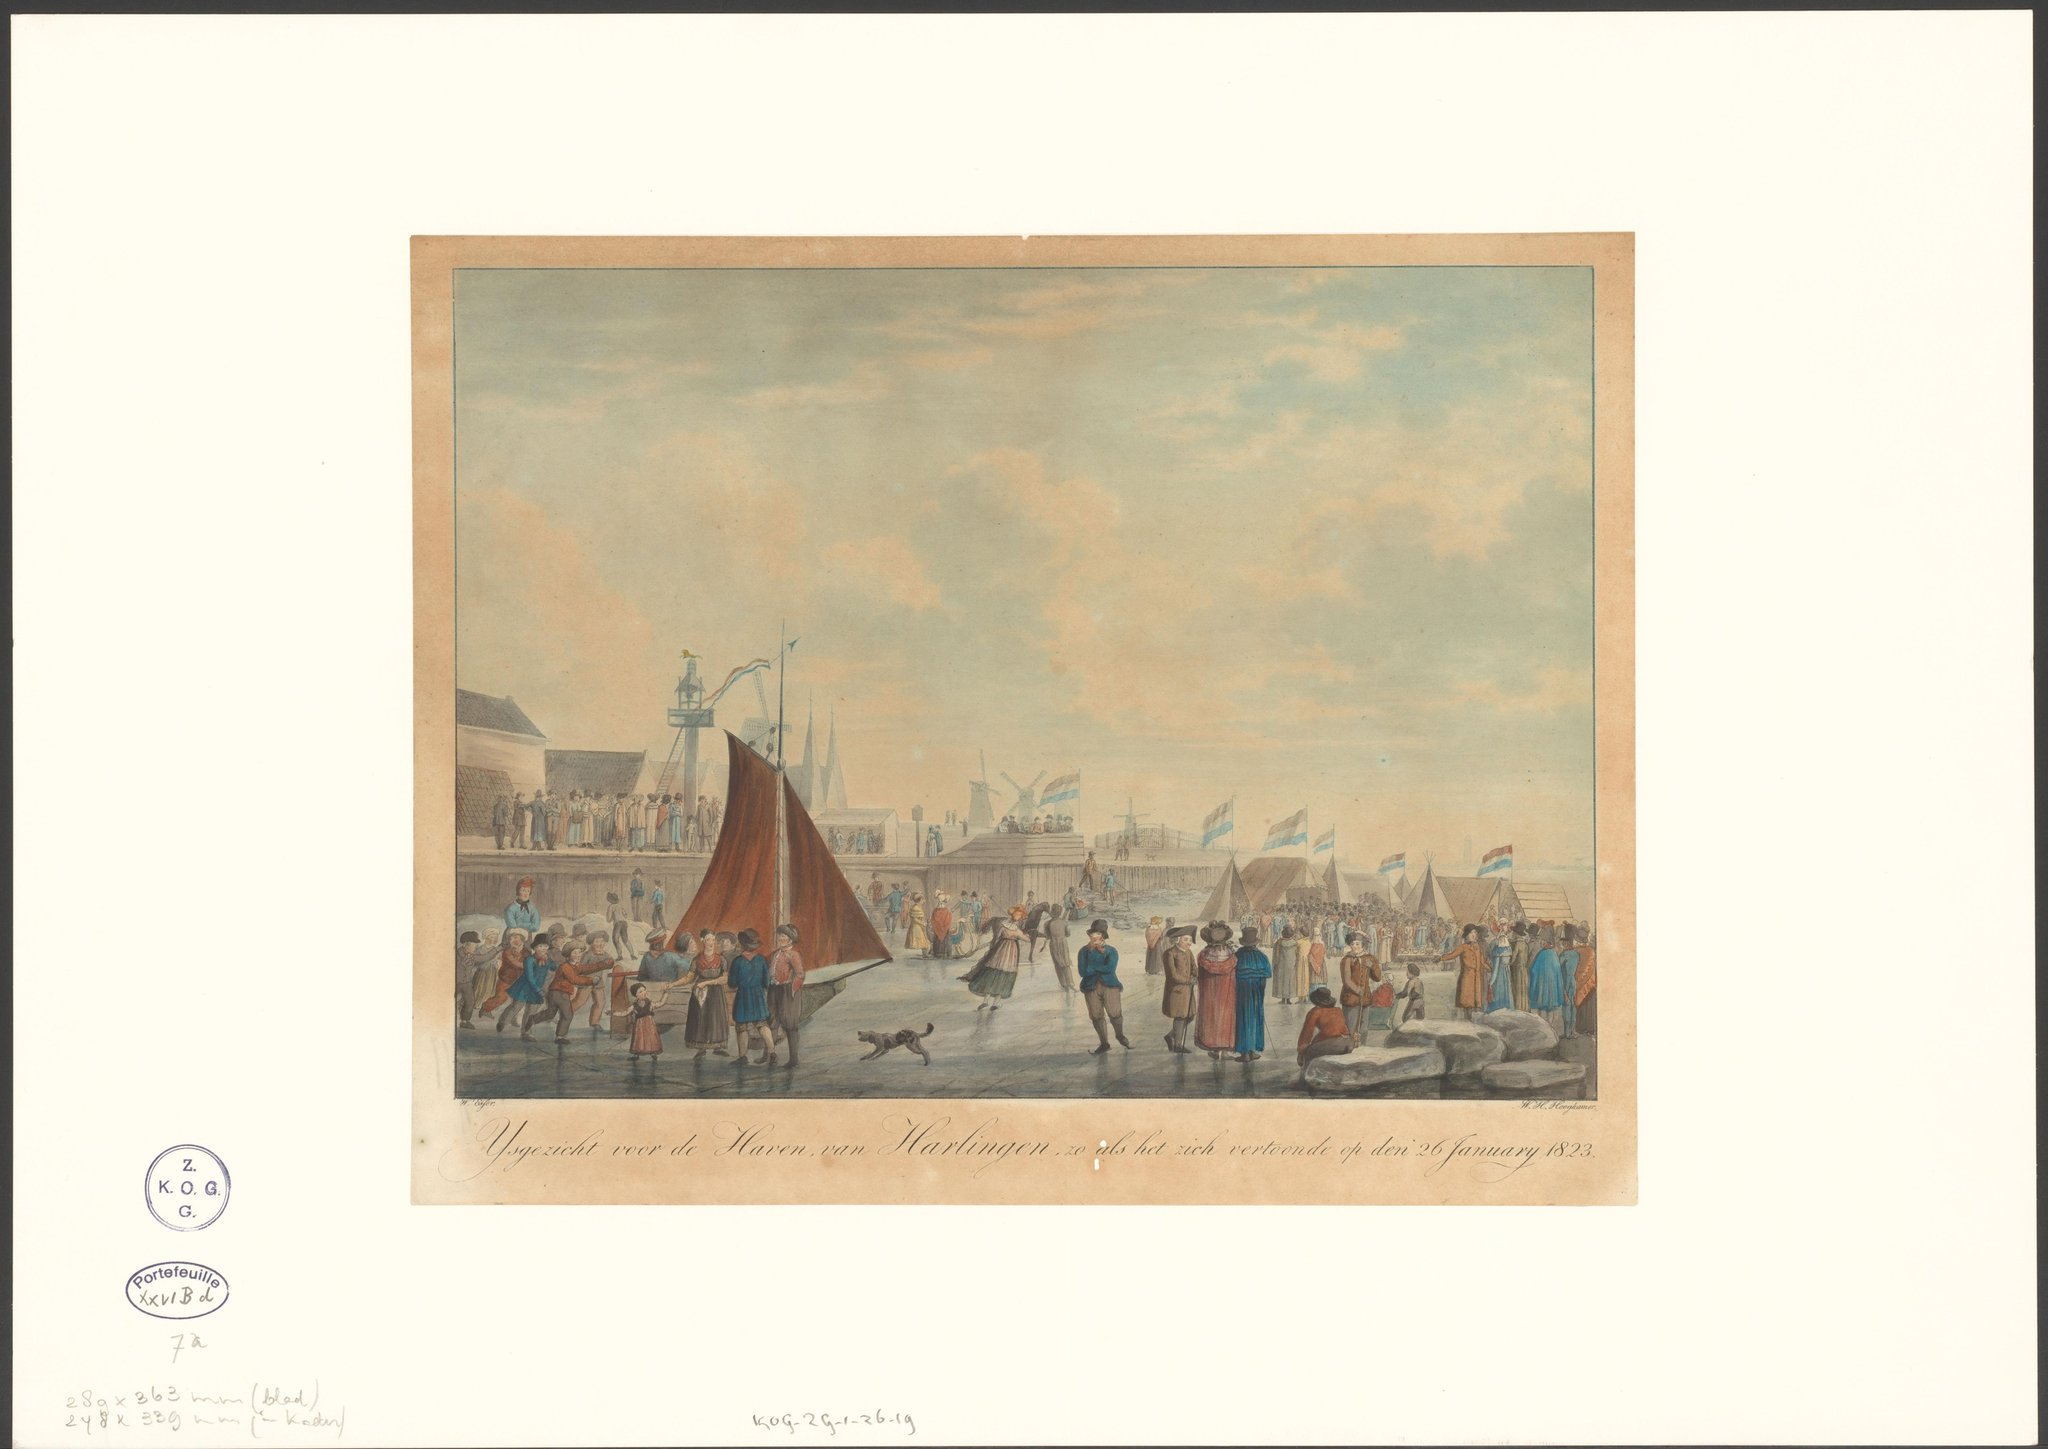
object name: print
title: IJspret op de dichtgevroren haven van Harlingen, 26 januari 1823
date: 1823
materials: paper, watercolor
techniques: aquatint, etching, hand coloring, lithography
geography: netherlands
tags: ice-sailing (winter sports), ice ~ freezing weather, skates (winter sports), sledge, sleigh (winter sports), severe winters, harlingen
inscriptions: collector's mark, collector's mark: Lugt 1641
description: Links een ijsschuit achtervolgd door een groep kinderen, rechts tenten op het ijs waar eten en drinken wordt verkocht (koek en zopie), in het midden een slee en enkele schaatsers. Zie ook de pendant. Onderwerpsrubrieken binnen de Atlas Zeden en Gewoonten: Spel en Vermaak; IJsvermaak, Strenge winters.